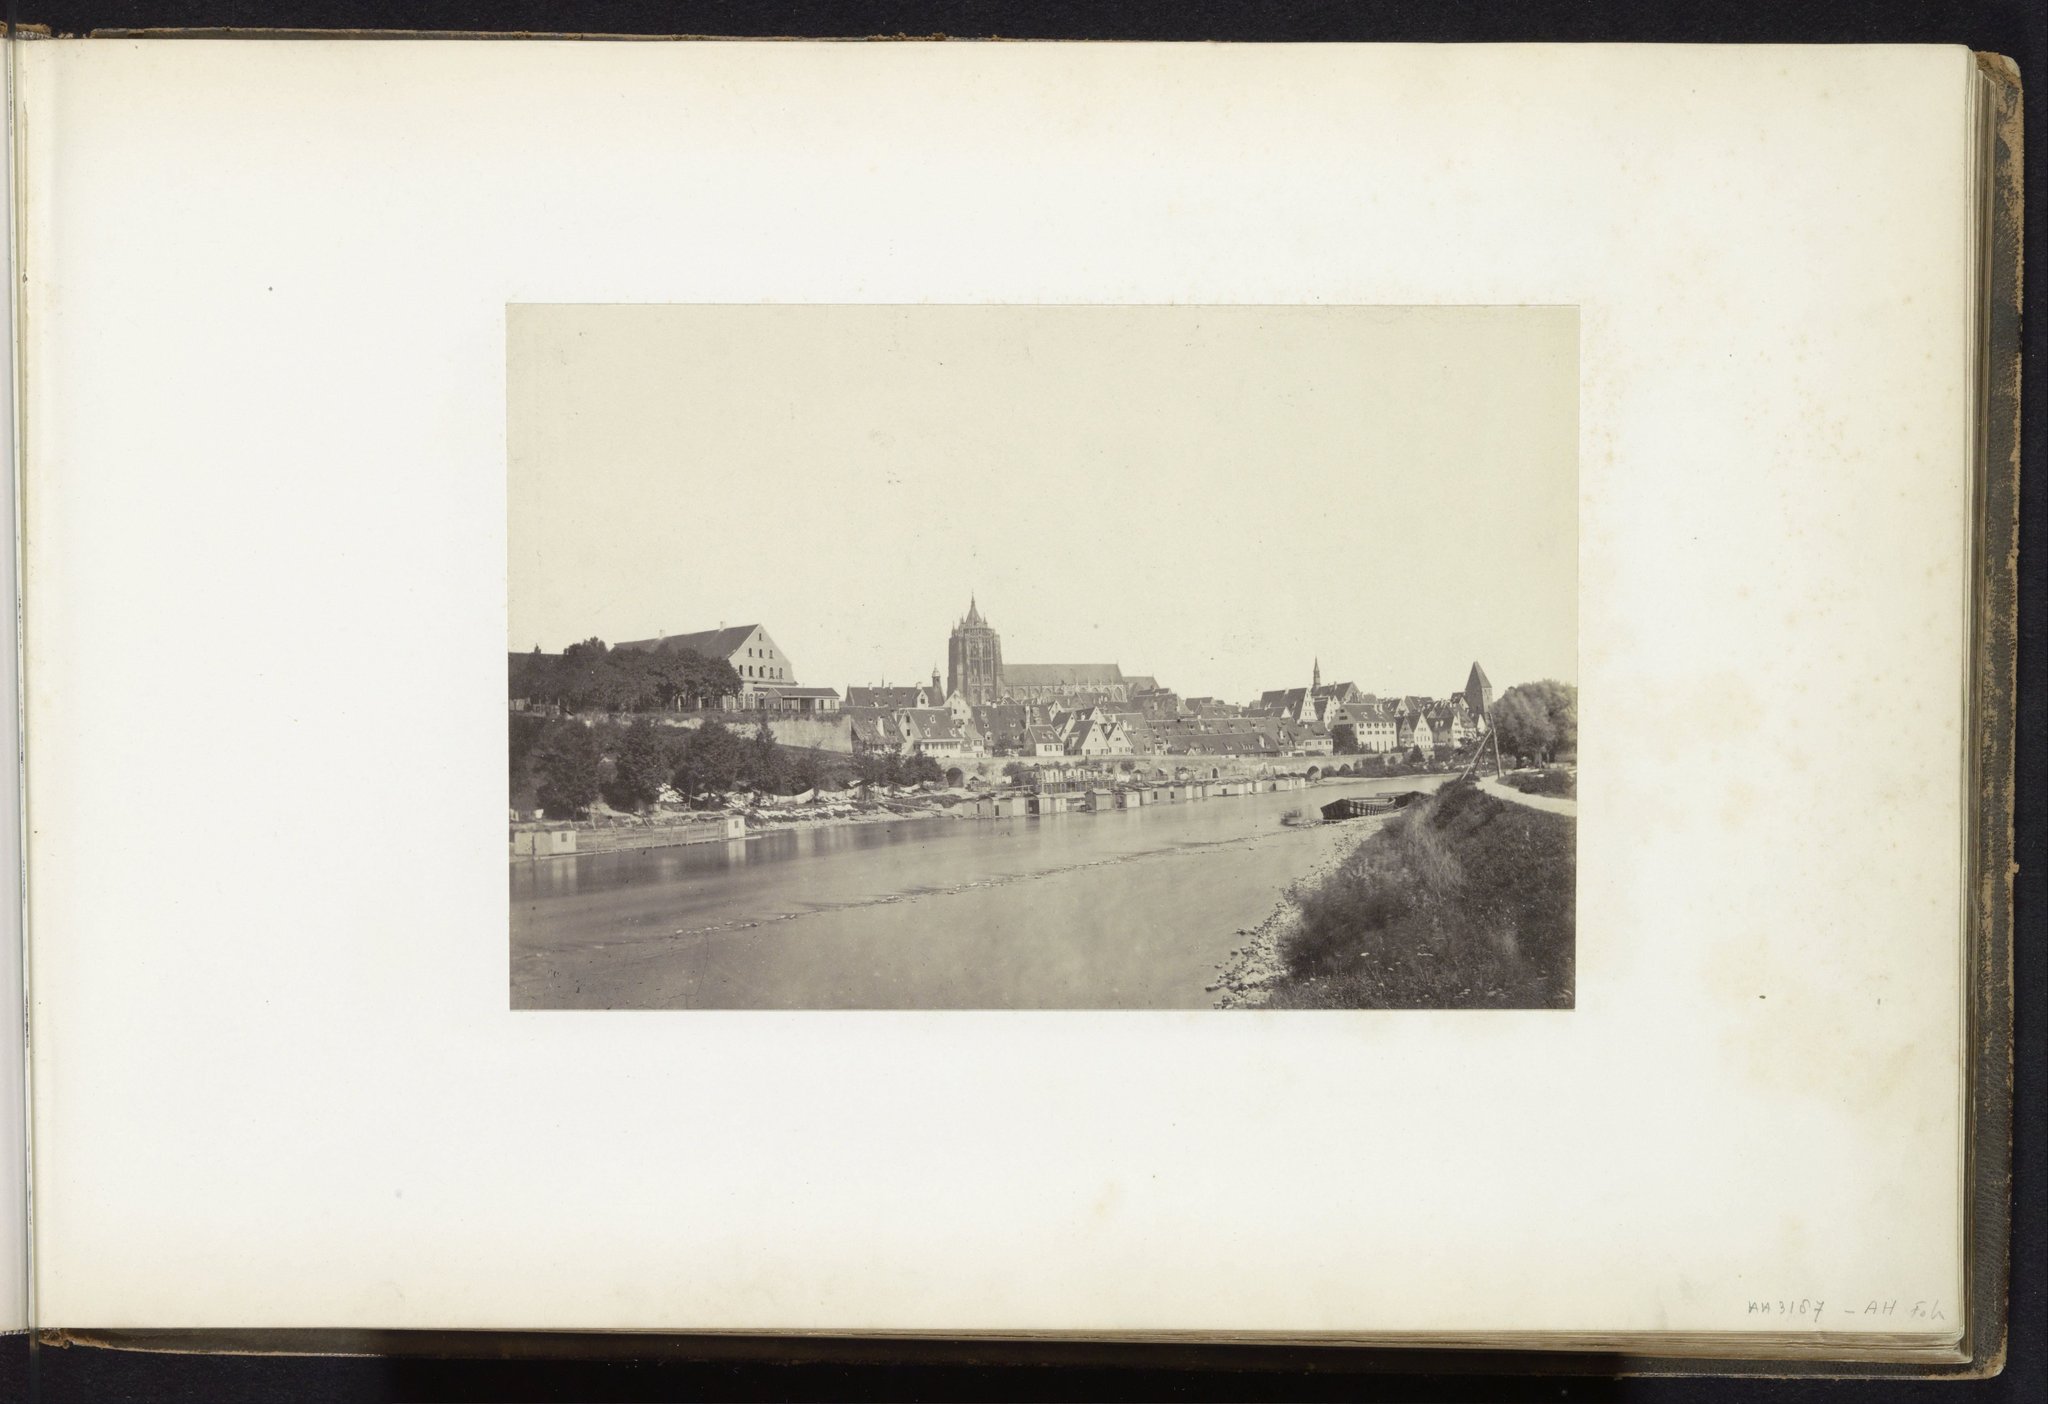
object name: photograph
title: Gezicht op een stad met kerk aan een rivier, vermoedelijk Midden-Europa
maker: Anonymous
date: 1865-1875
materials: photographic support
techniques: albumen print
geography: central europe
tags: church (exterior), river (+ landscape with figures, staffage), prospect of city, town panorama, silhouette of city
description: Onderdeel van Reisalbum met opnames van bezienswaardigheden in India, Duitsland, Zwitserland en Frankrijk.